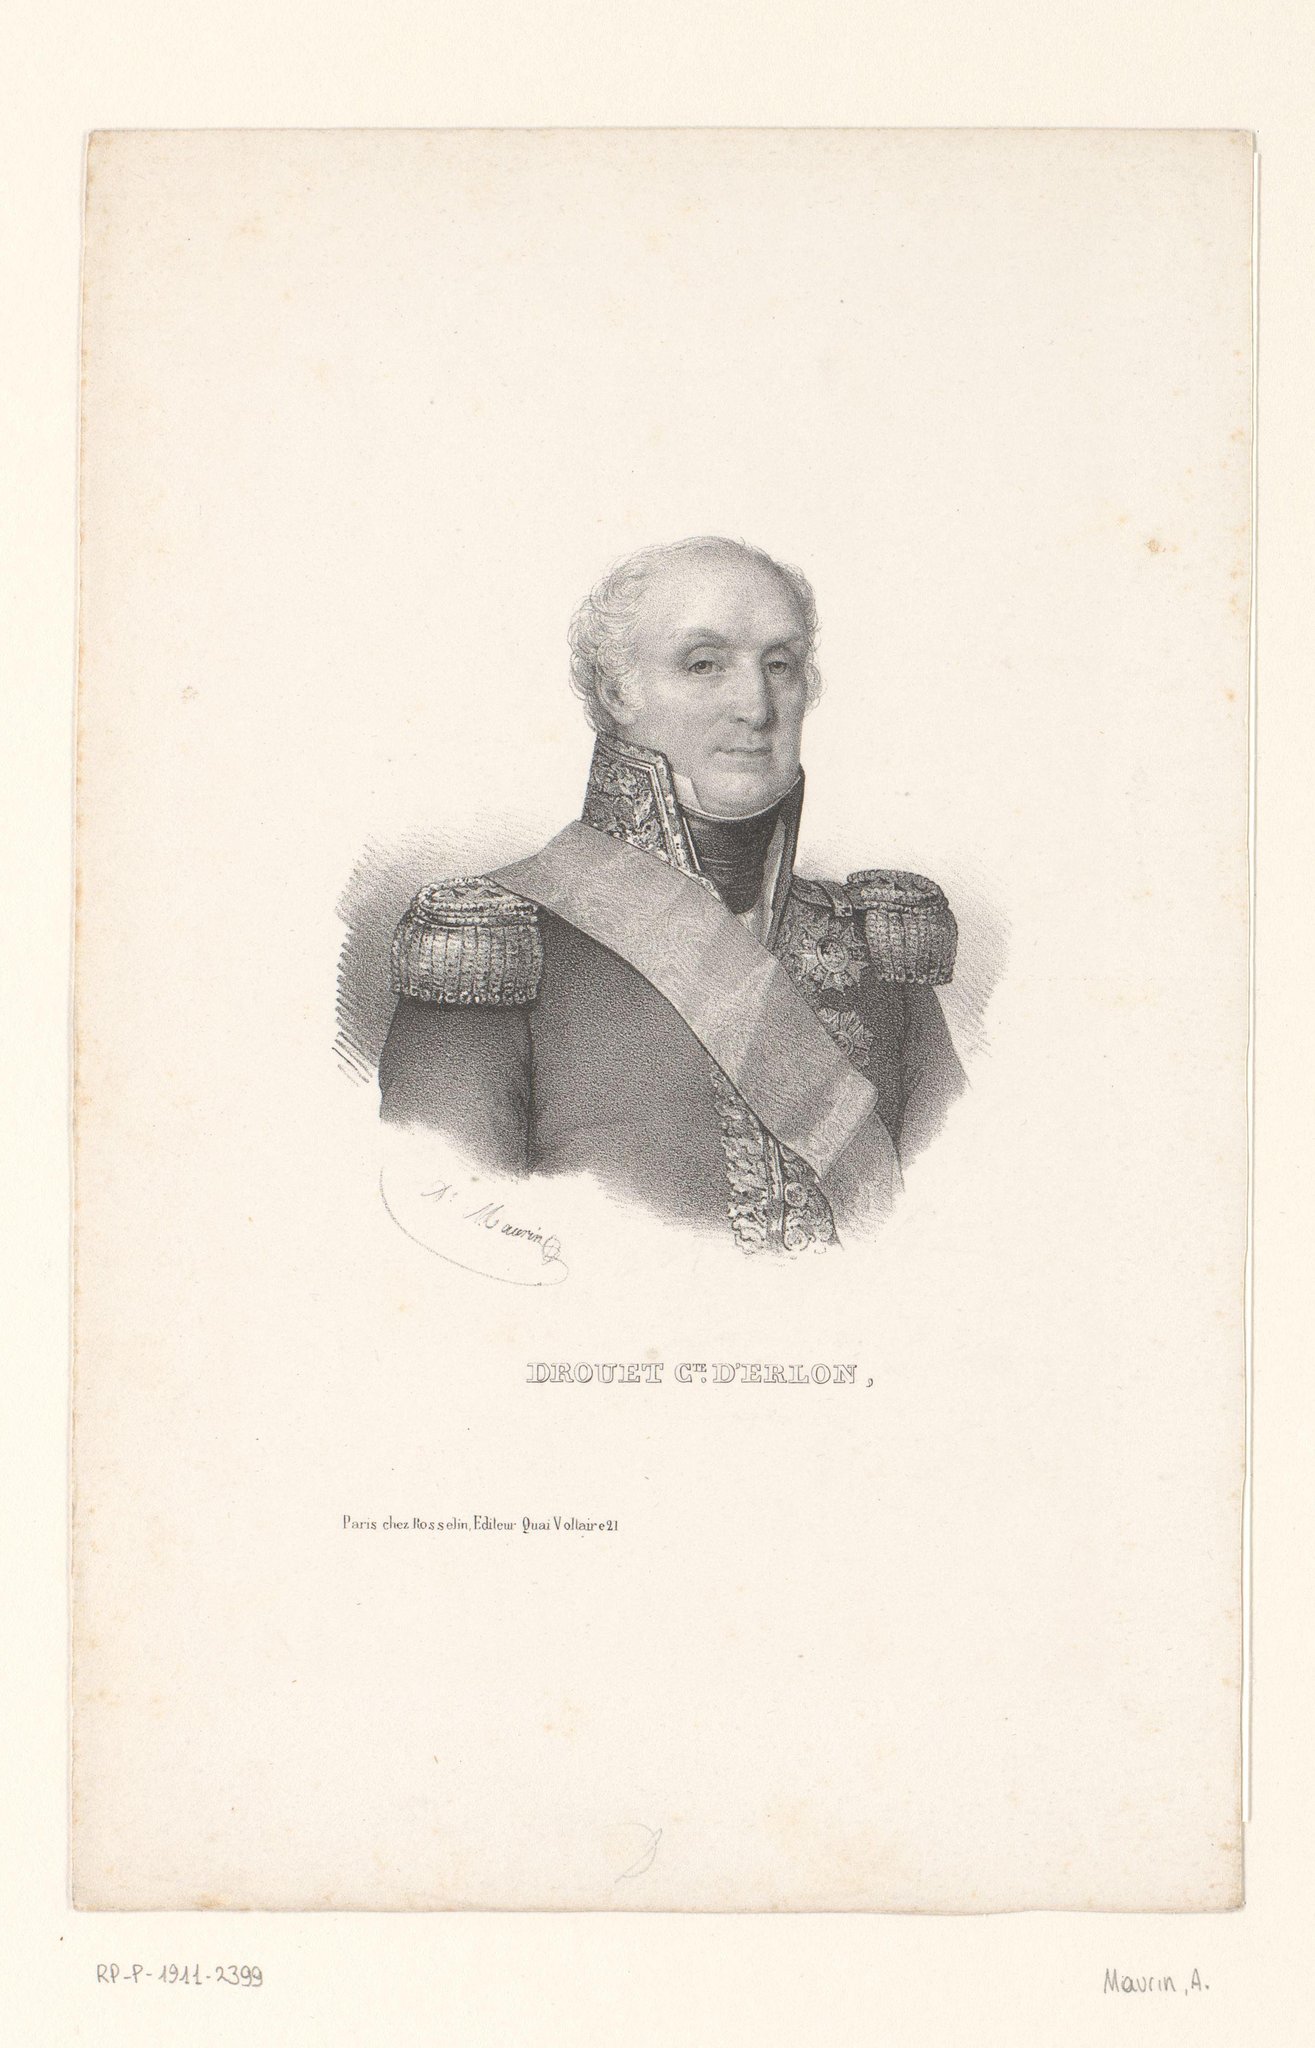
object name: print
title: Portret van Jean-Baptiste Drouet d'Erlon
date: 1834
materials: paper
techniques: lithograph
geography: paris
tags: paris, historical persons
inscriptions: collector's mark: Lugt 2228